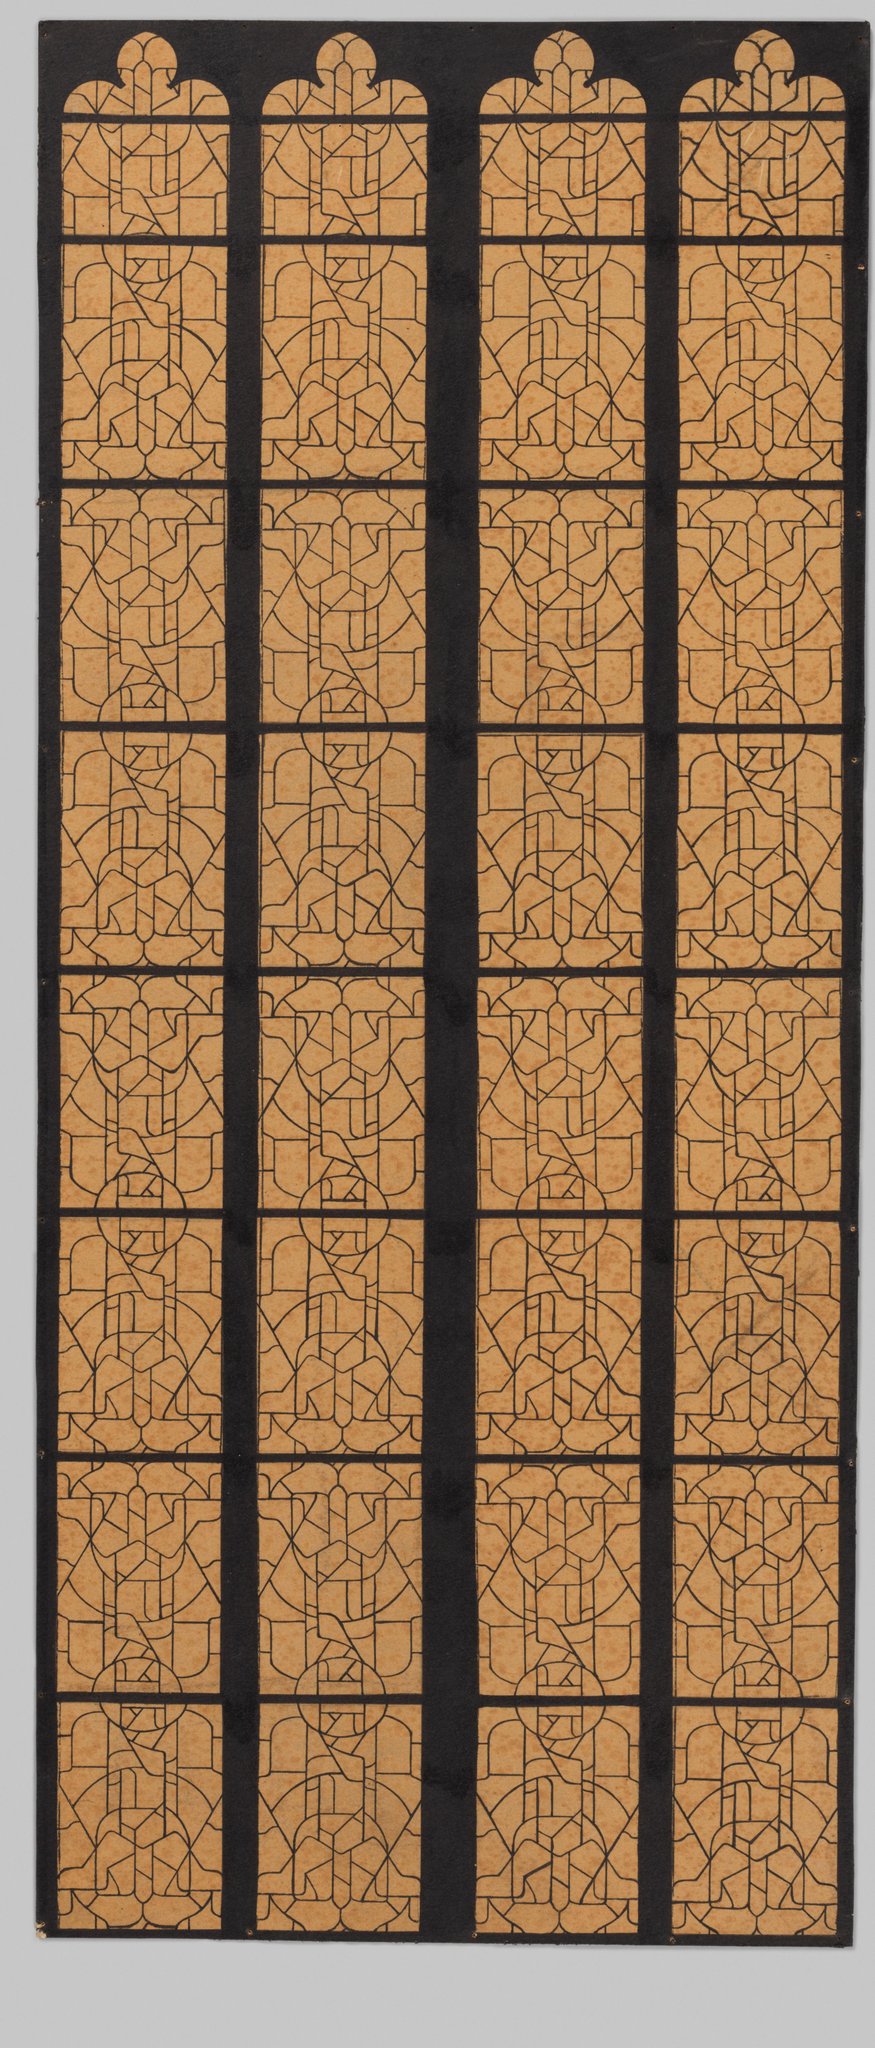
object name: drawing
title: Tapijtontwerp voor ramen in het Noordertransept in de Dom te Utrecht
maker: richard nicolaüs roland holst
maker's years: 1868-1938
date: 1878-1938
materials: cardboard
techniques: brush